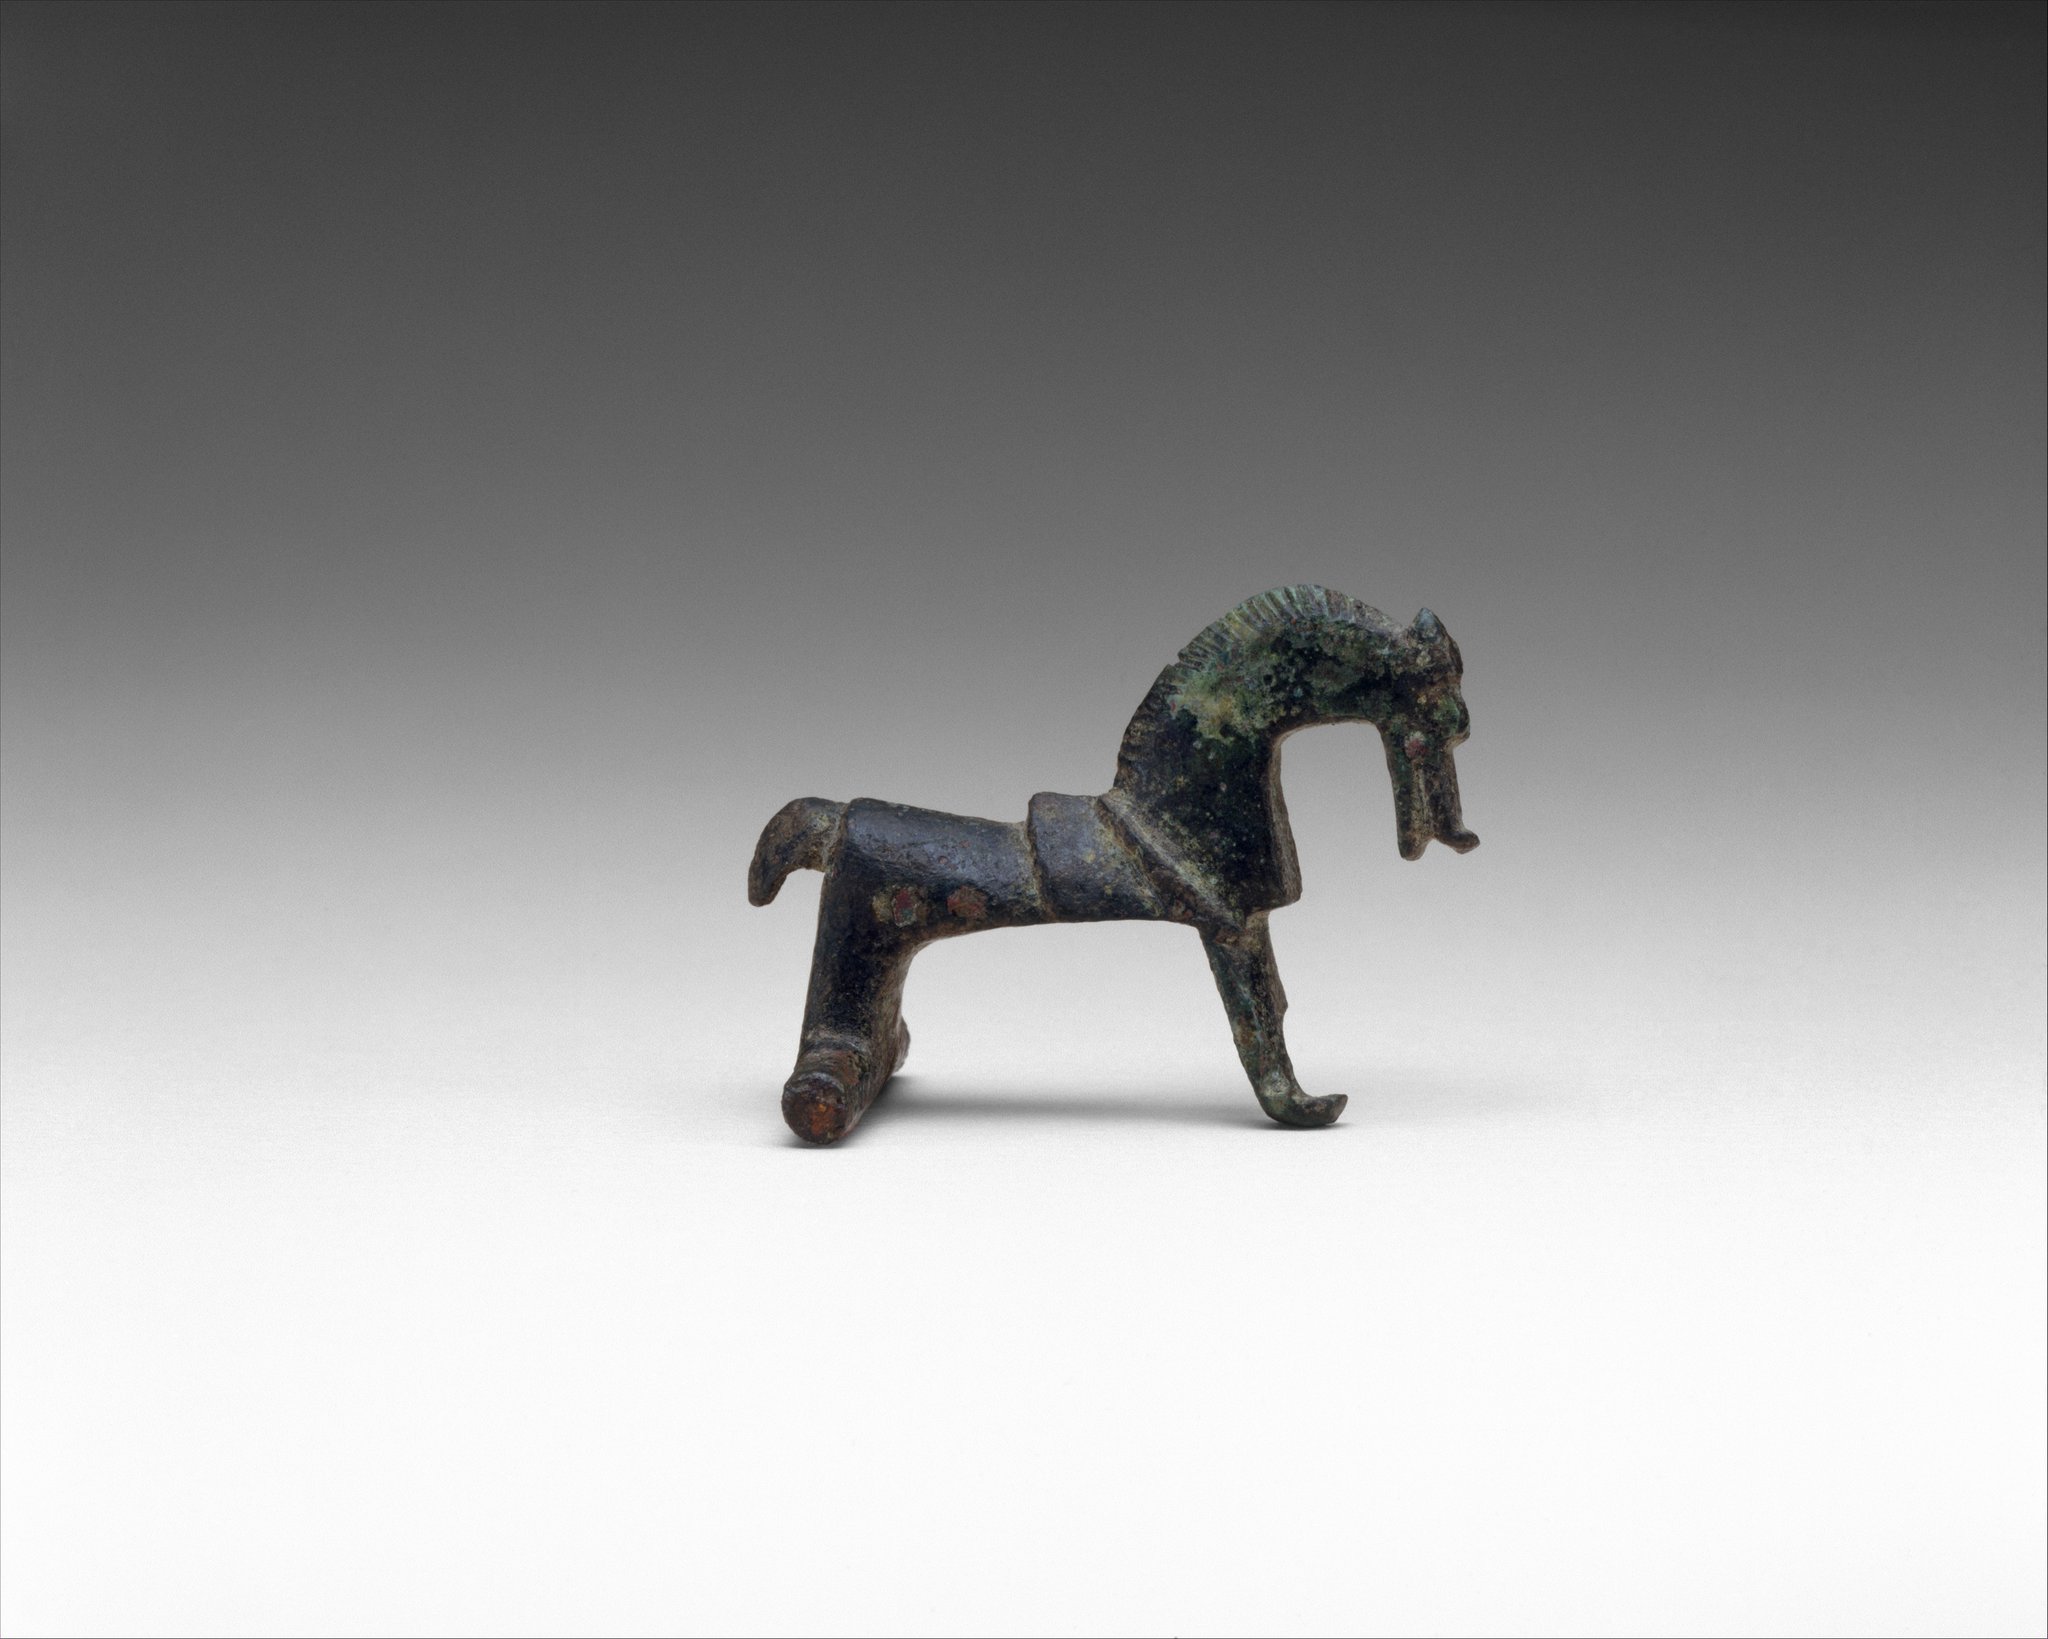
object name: brooch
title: Horse-Shaped Brooch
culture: celtic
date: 650-550 BCE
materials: bronze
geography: central europe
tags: horses